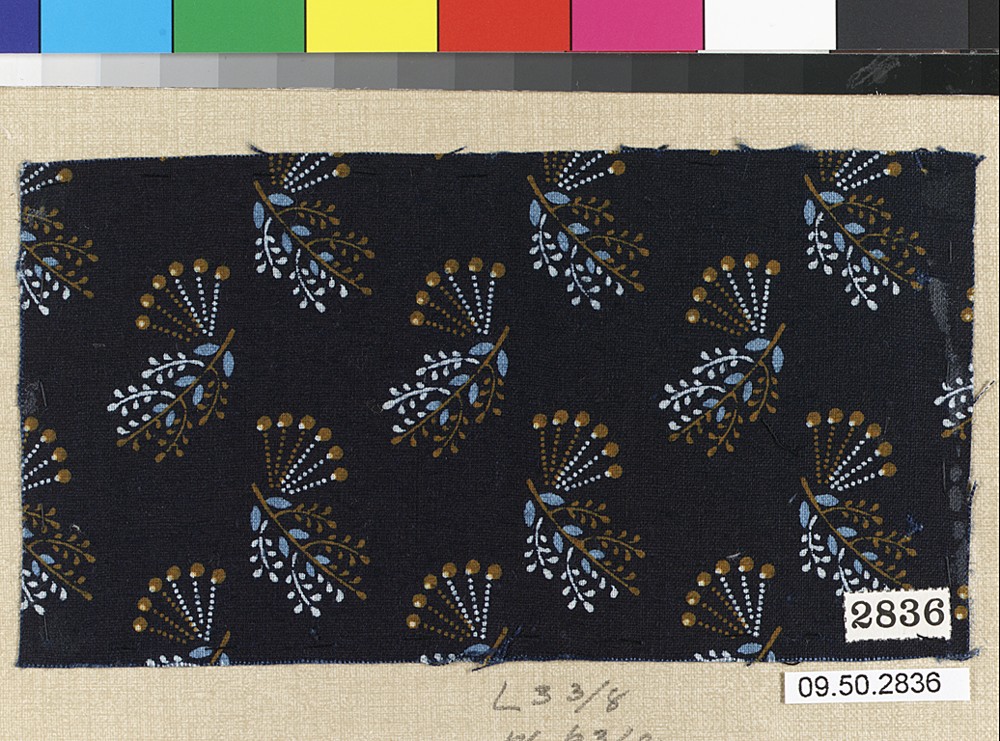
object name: piece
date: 1801-1900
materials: cotton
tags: leaves